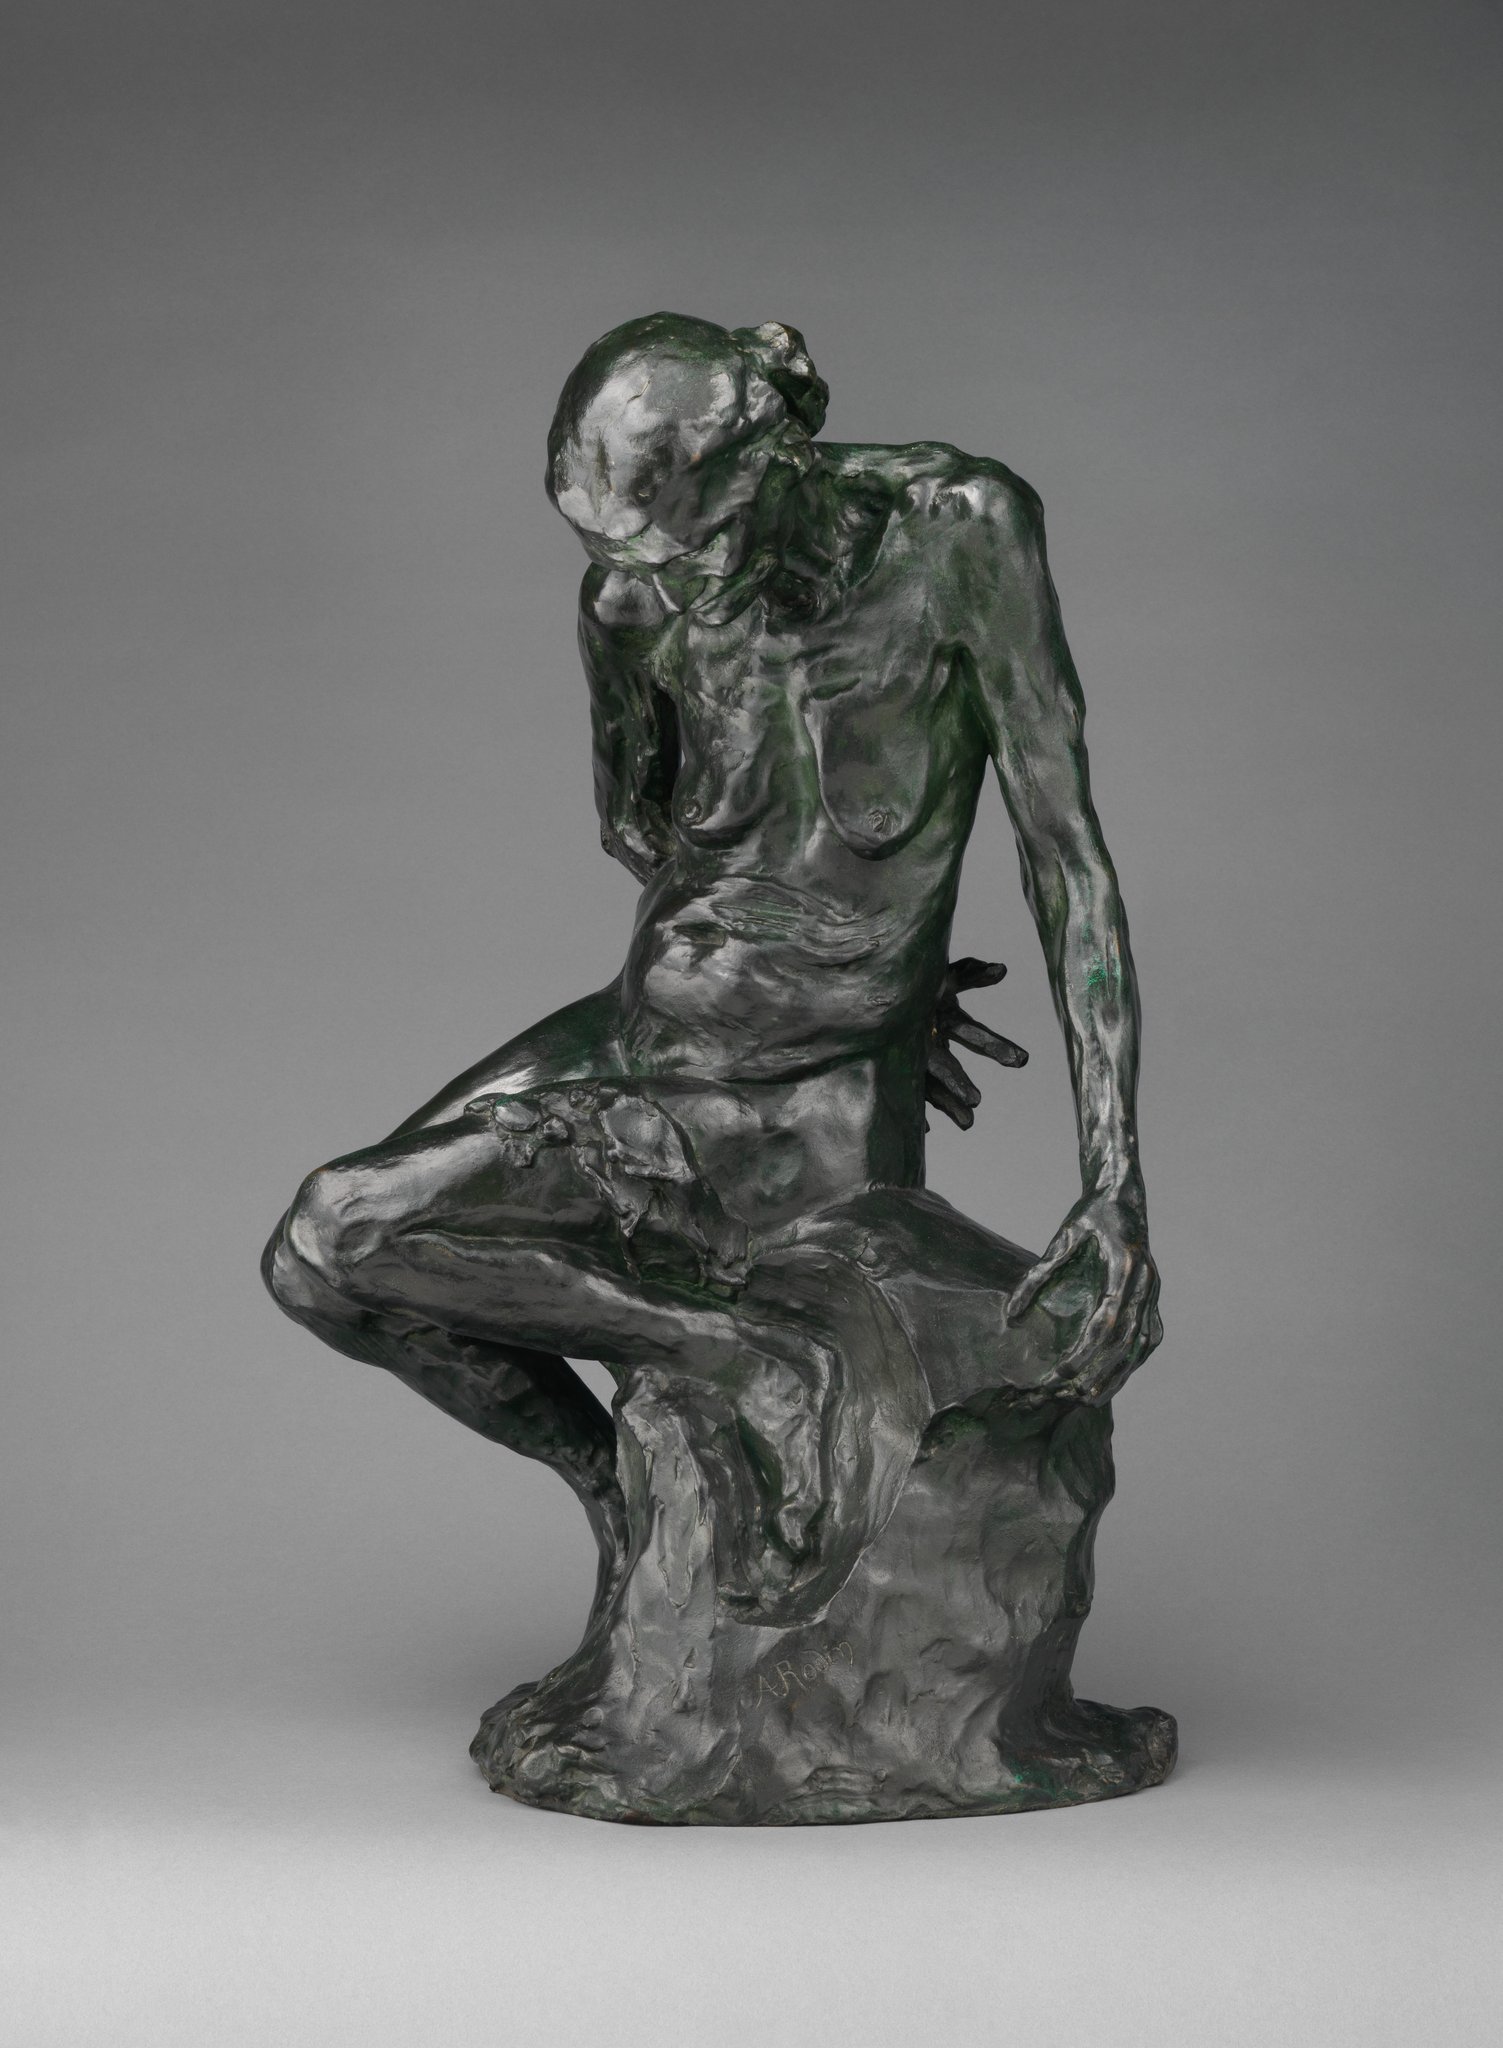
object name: statuette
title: The Old Courtesan (La Belle qui fut heaulmière)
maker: auguste rodin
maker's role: artist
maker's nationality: french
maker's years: 1840-1917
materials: bronze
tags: female nudes